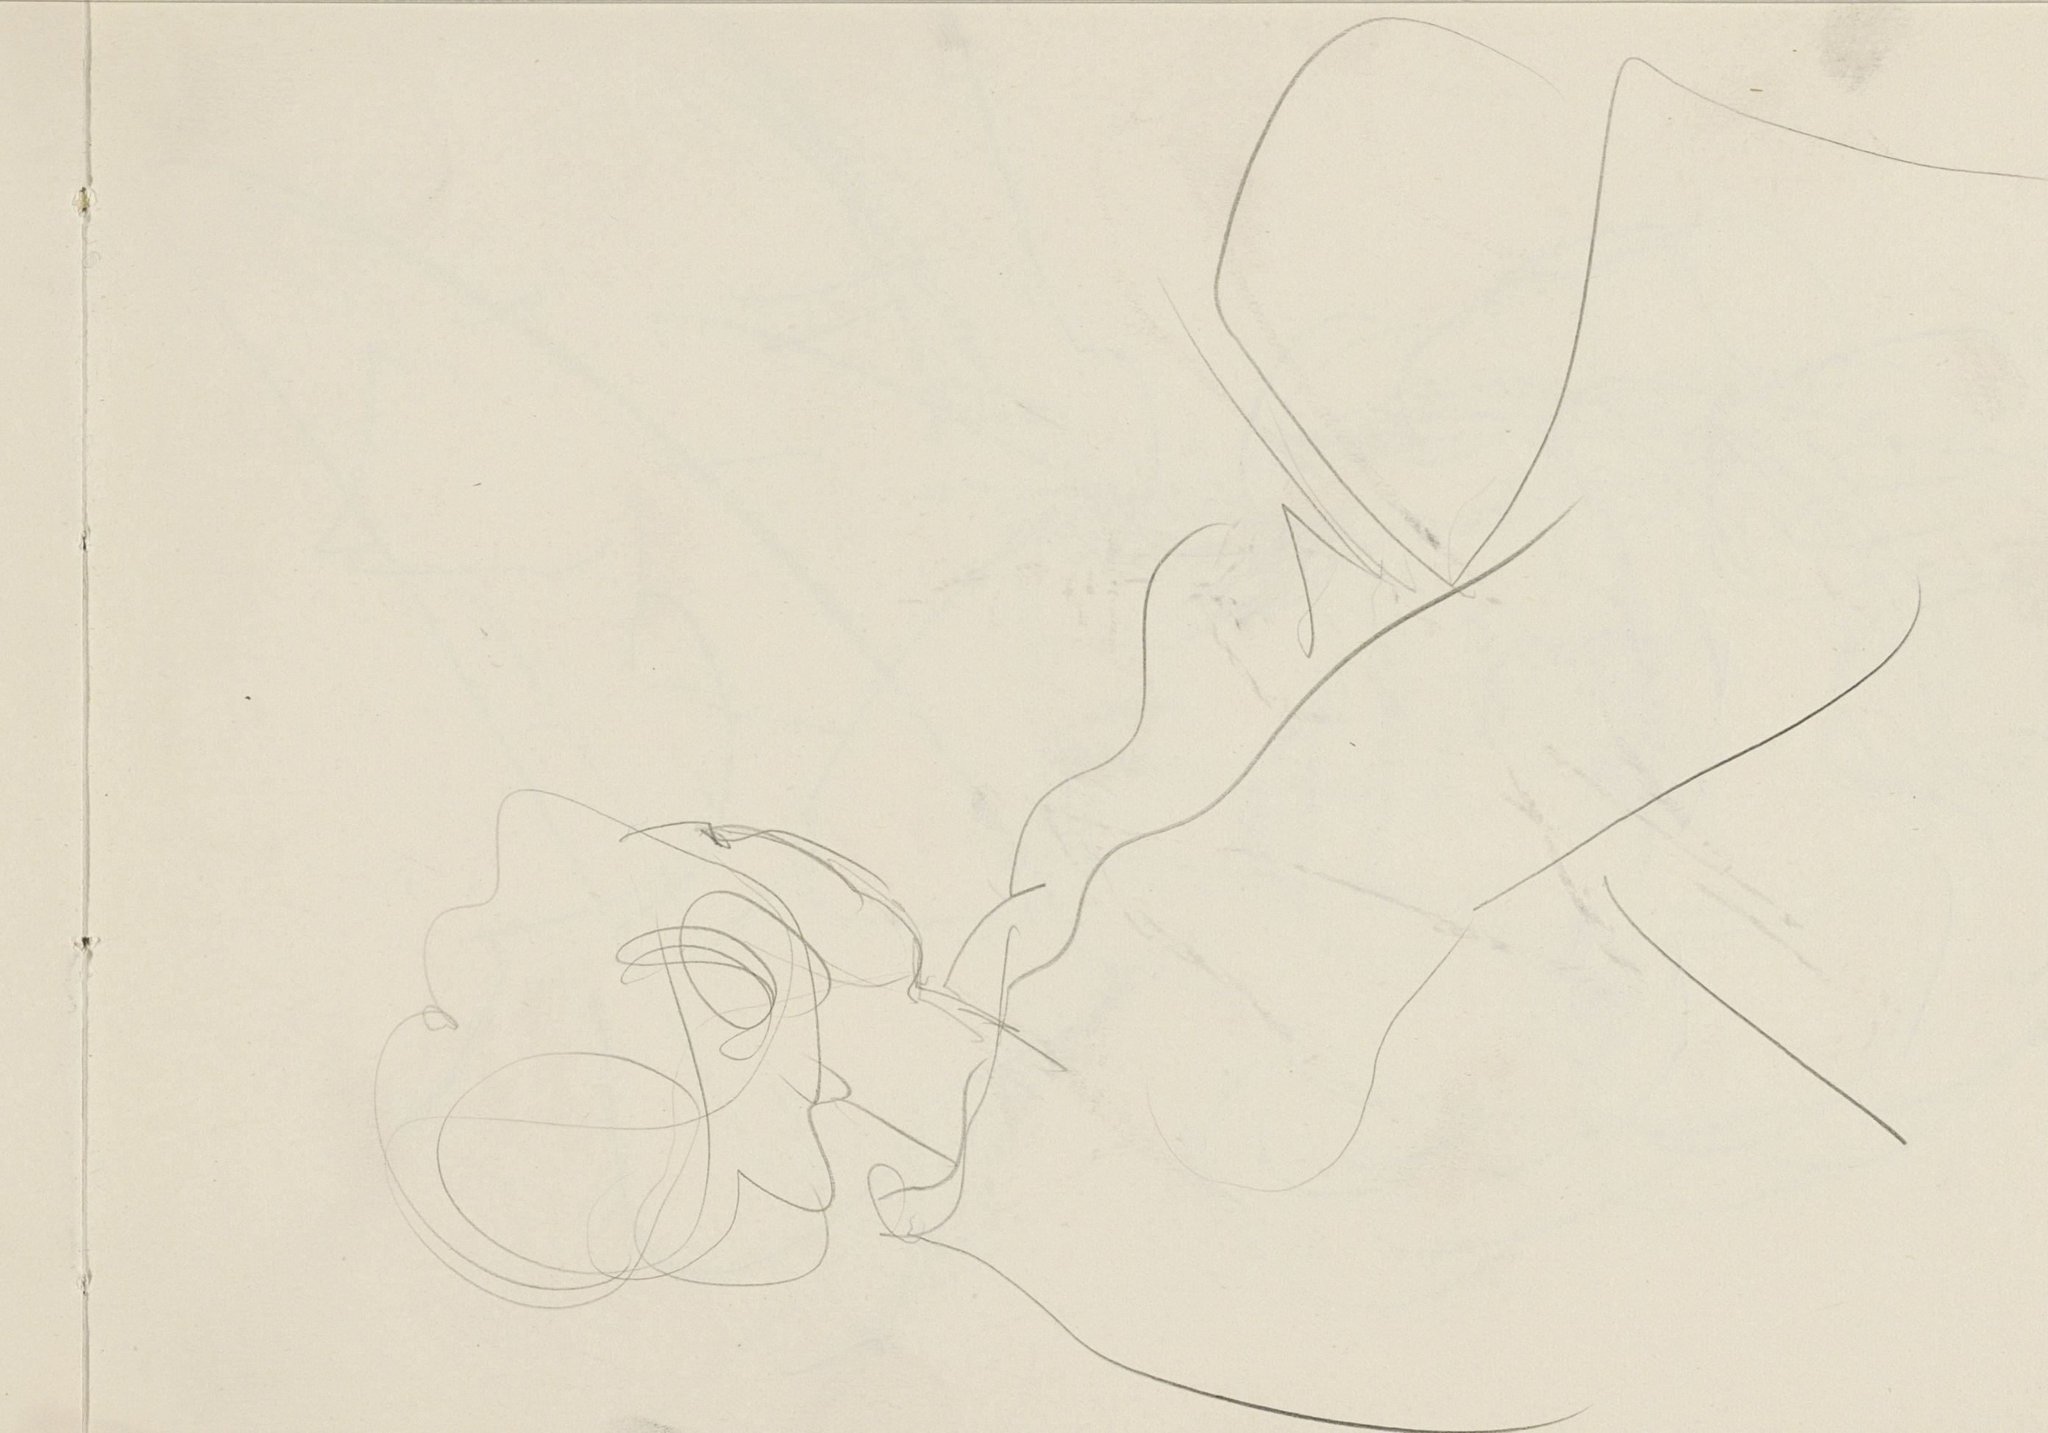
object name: sketchbook leaf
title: Vrouw met muts, in profiel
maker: isaac israels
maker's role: draughtsman, painter, print maker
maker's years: 1865-1934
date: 1915-1934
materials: paper, pencil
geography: the hague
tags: adult woman (+ sideview, profile)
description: Blad 12 recto uit schetsboek XXV met 23 bladen.